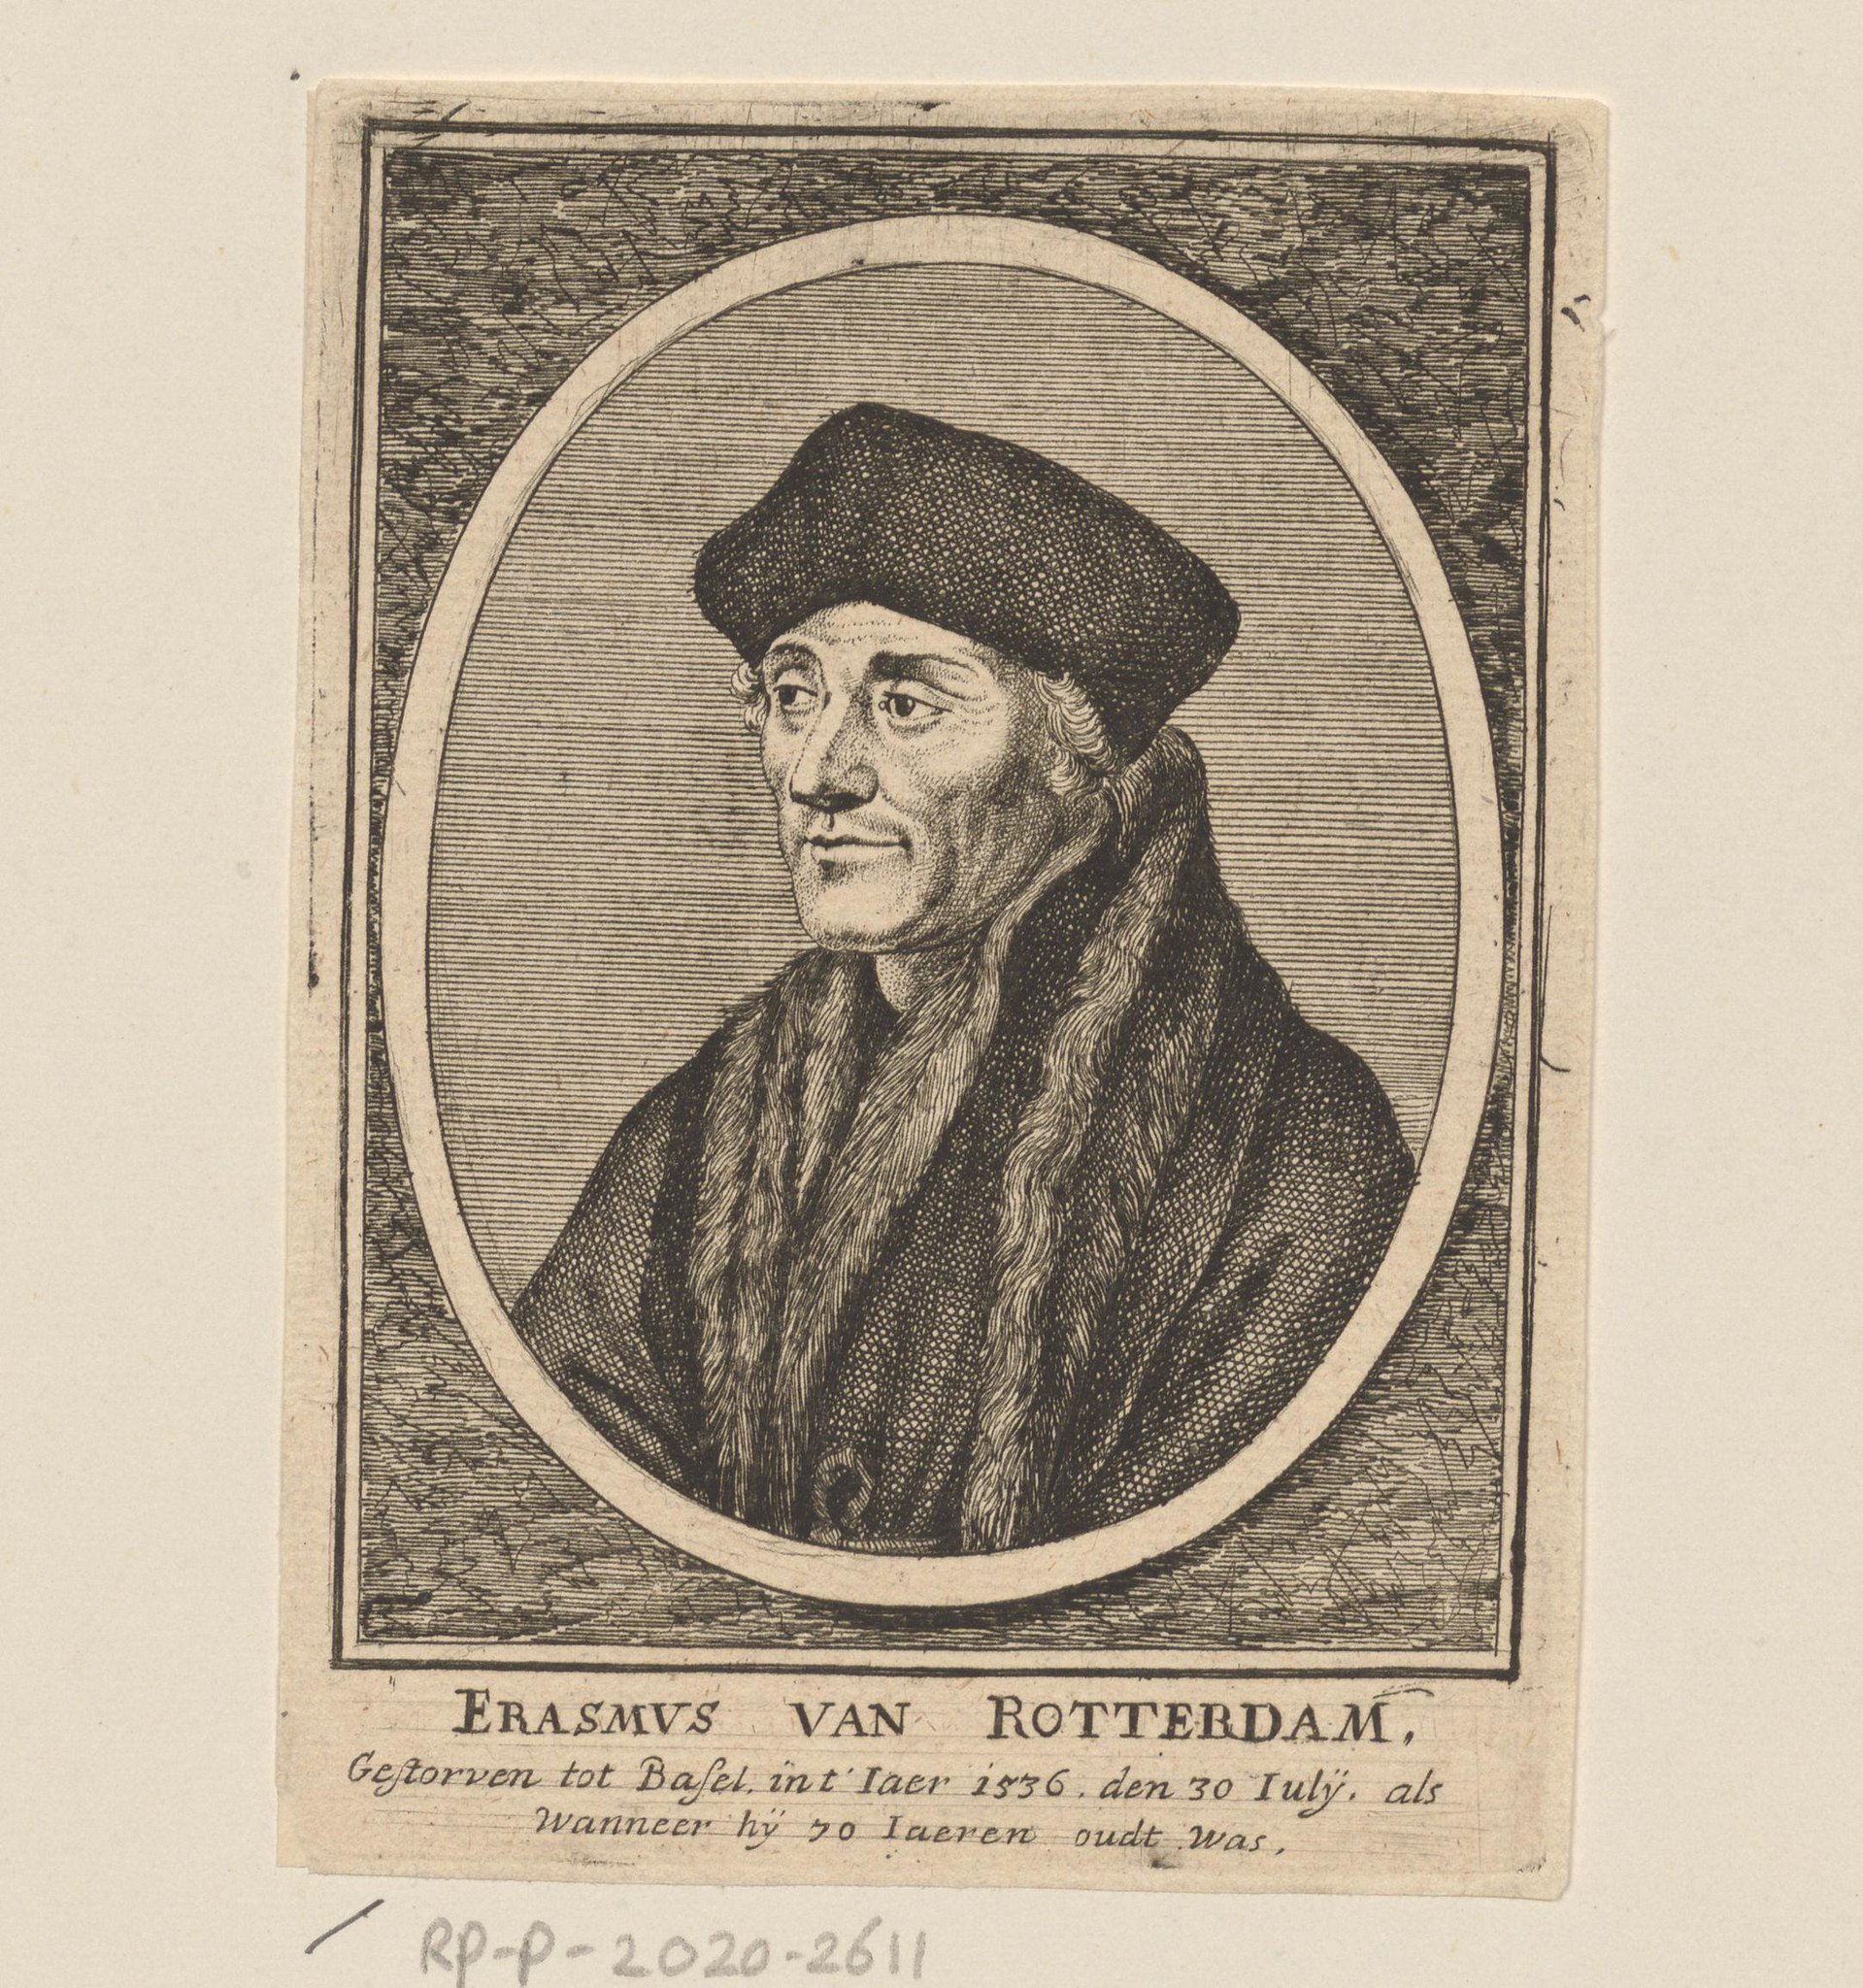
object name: print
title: Portret van Desiderius Erasmus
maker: Anonymous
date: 1650-1750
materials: paper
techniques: etching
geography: northern netherlands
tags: rotterdam, desiderius erasmus, historical persons, scholar, philosopher (+ portrait of scholar, scientist)